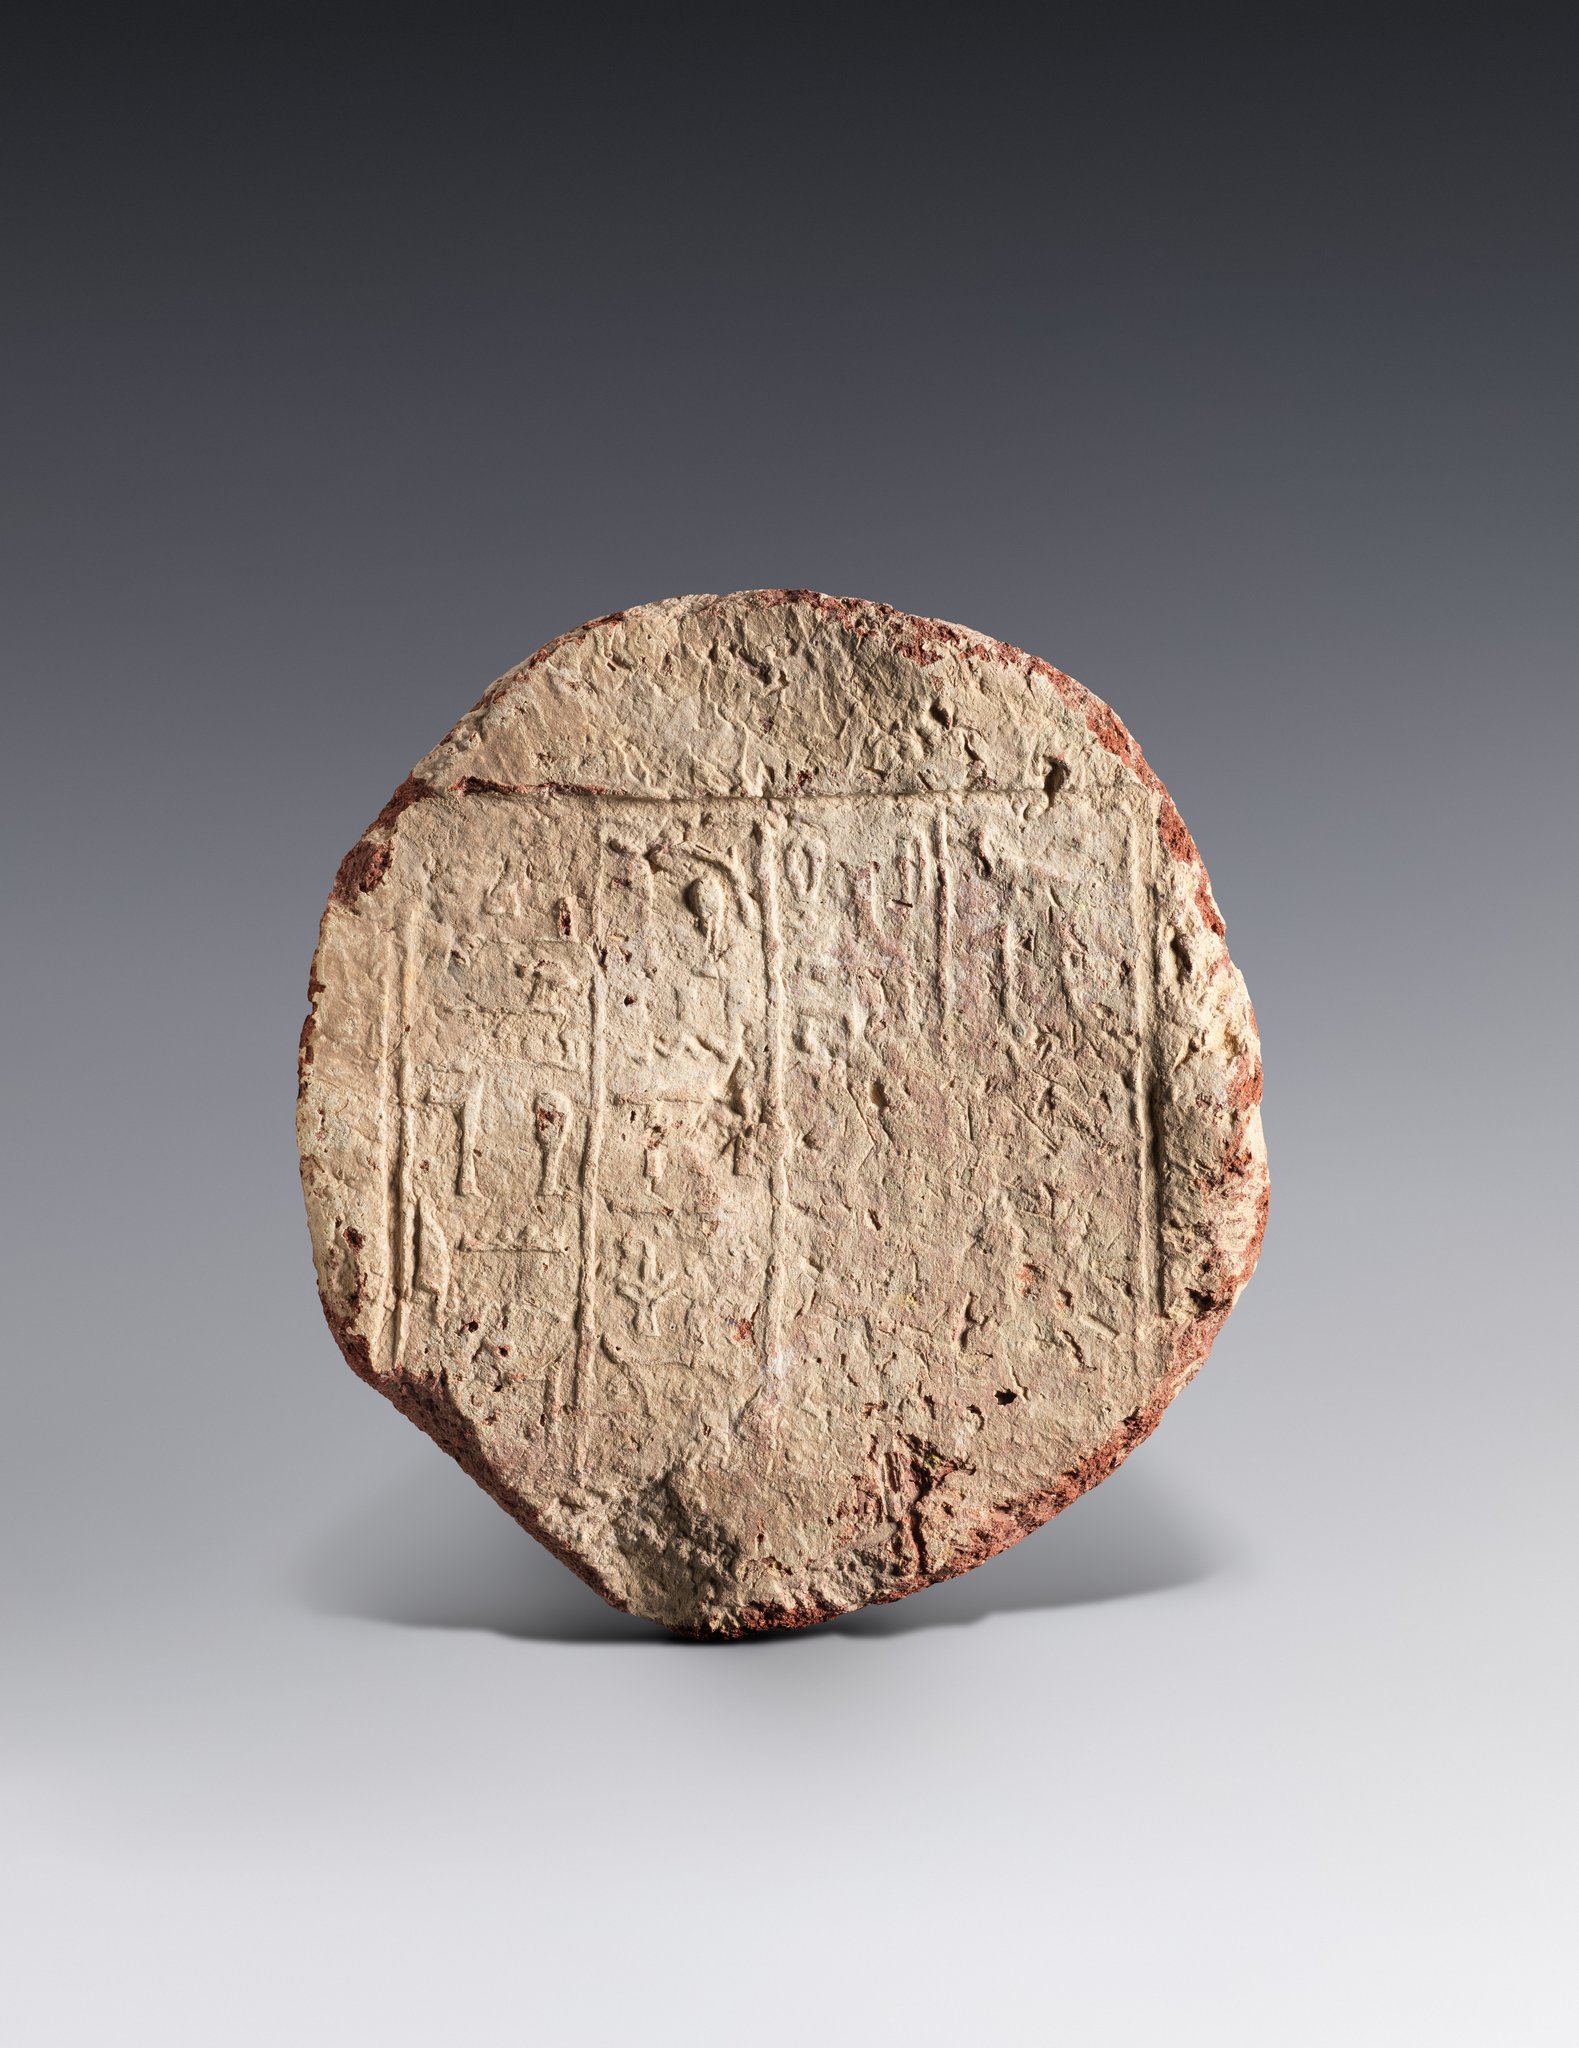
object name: cone, pabasa, round,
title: Funerary Cone of Pa-ba-sa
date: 712-525 BCE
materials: pottery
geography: egypt